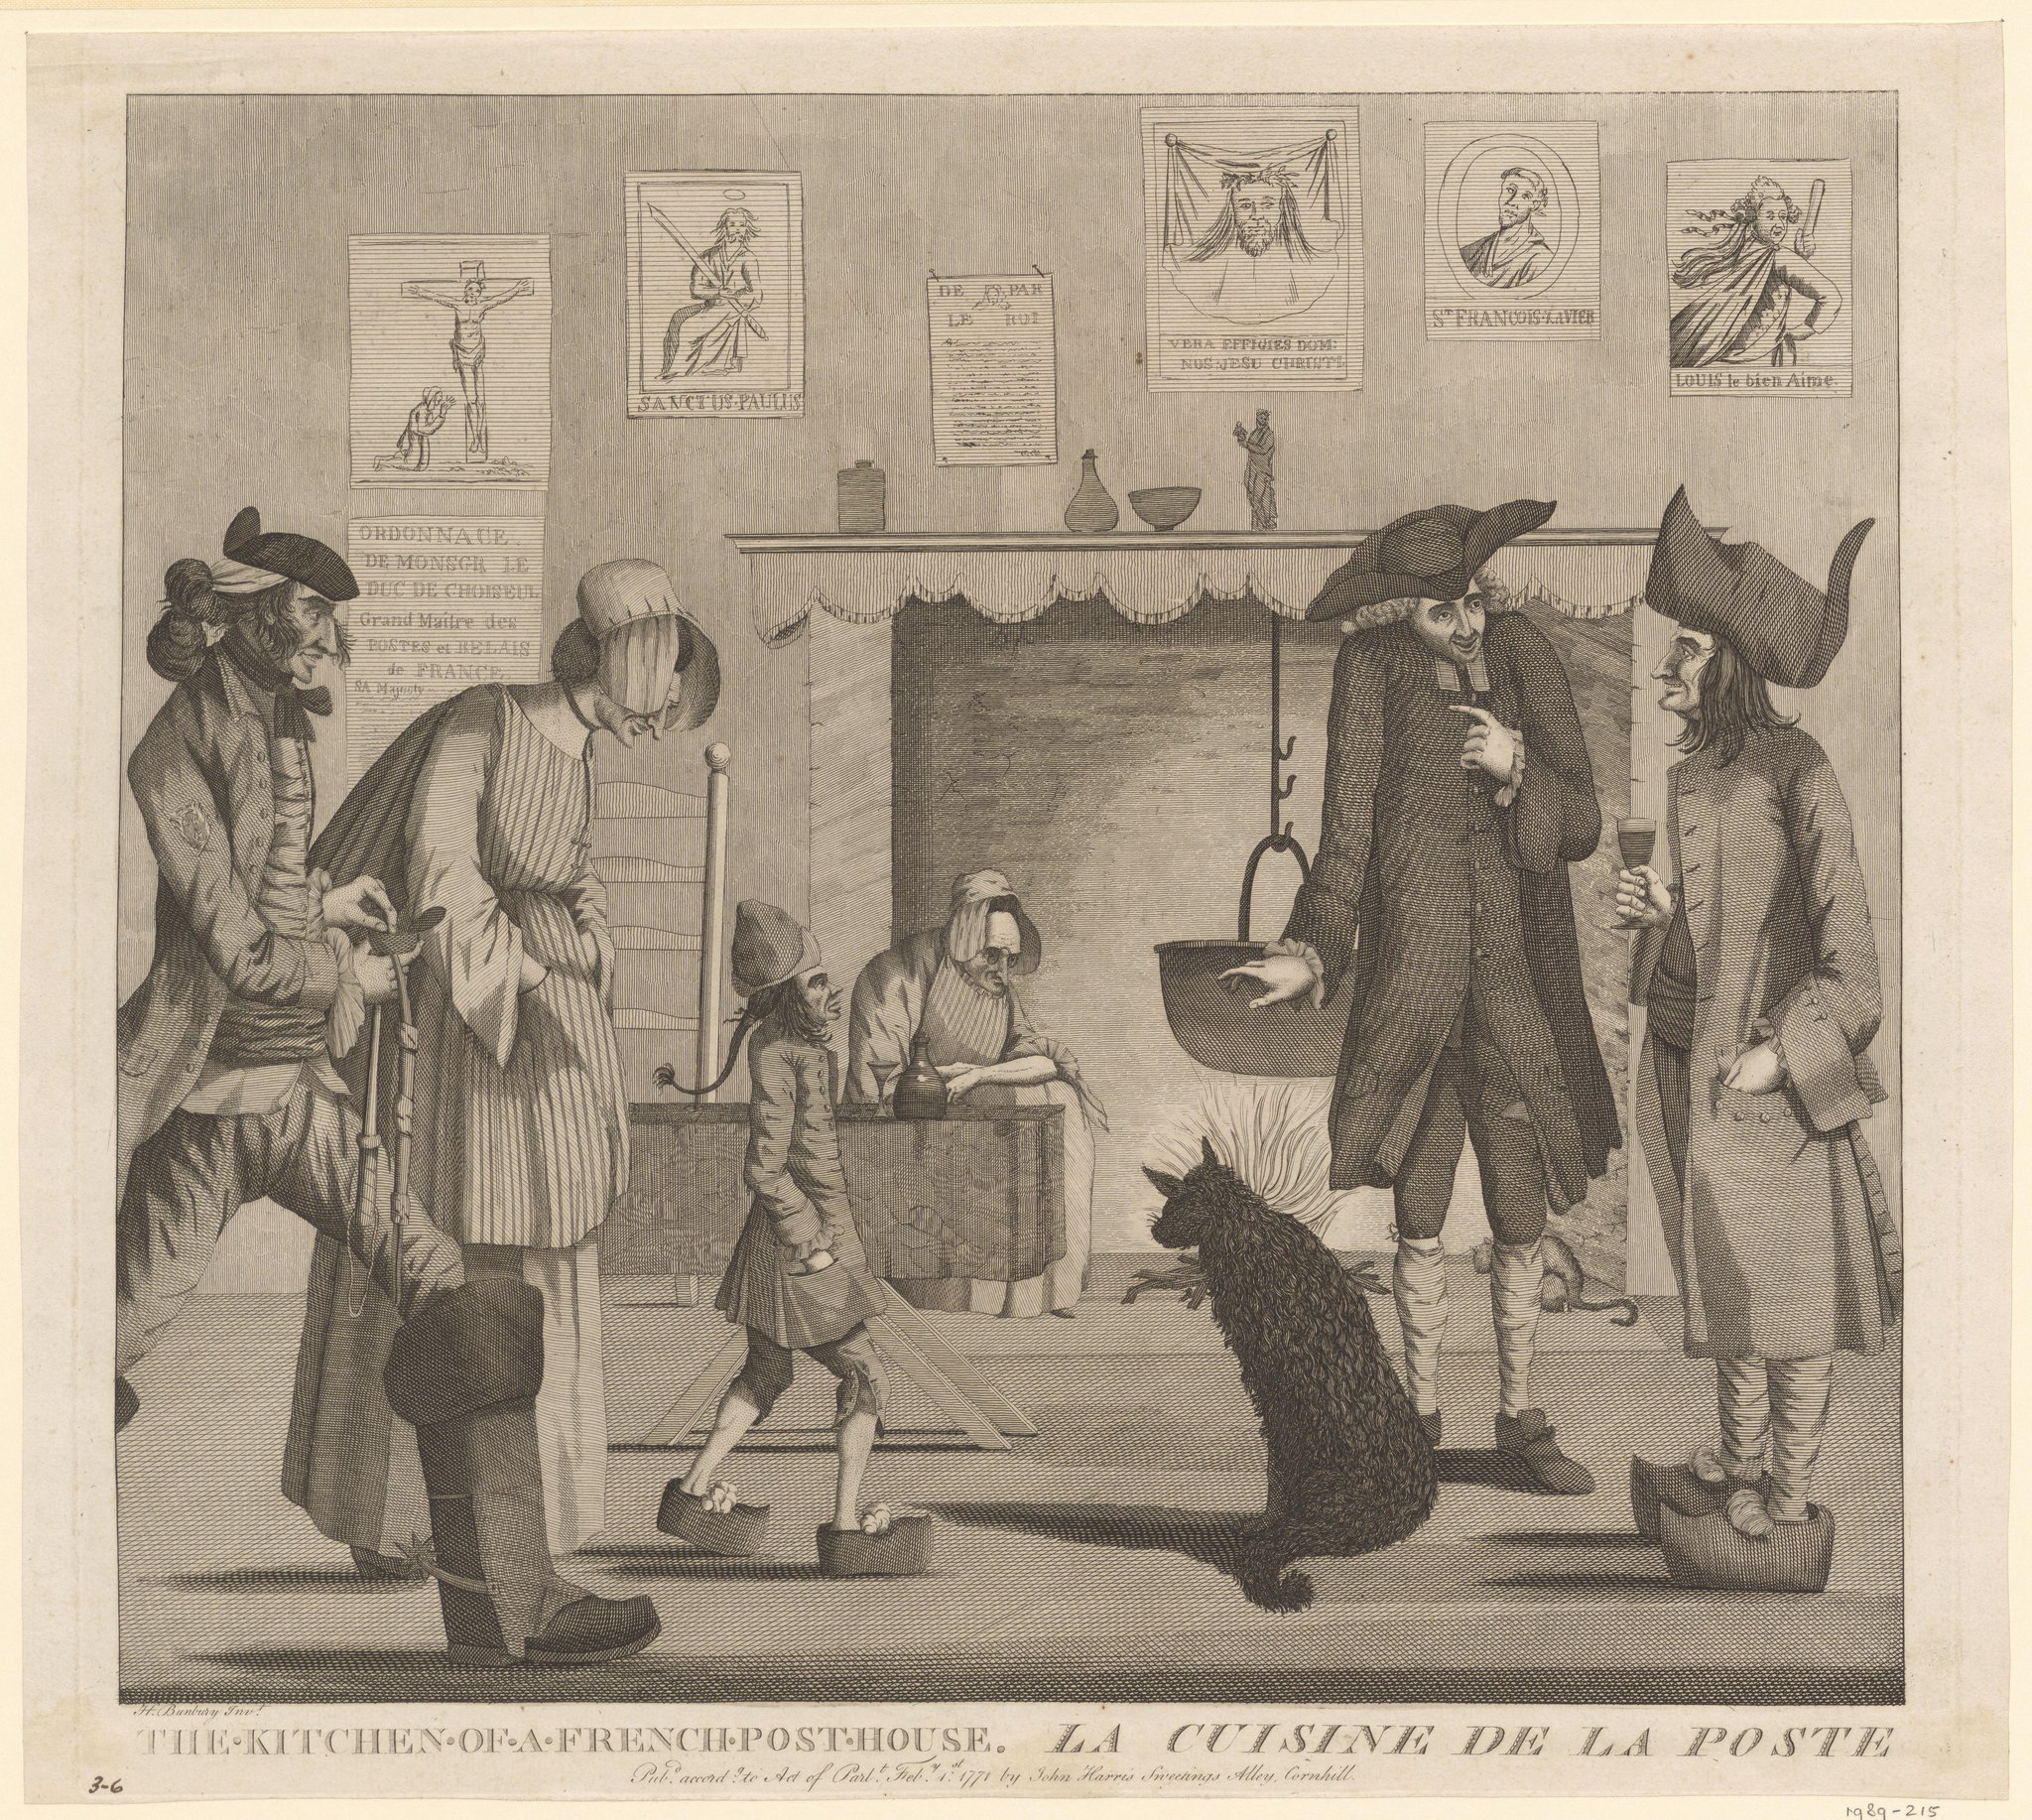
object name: cartoon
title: The kitchen of a French Post House / La cuisine de la poste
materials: paper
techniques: etching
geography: london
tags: kitchen, 'vera icon', 'sudarium', veronica-portrait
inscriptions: collector's mark: Lugt 2760, annotation: ‘3-6’, collector's mark: Lugt 2228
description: Tekst in het Engels en het Frans in de ondermarge. In de voorstelling zijn vijf Christelijke populaire prenten en ordonnanties op de muur geplakt.